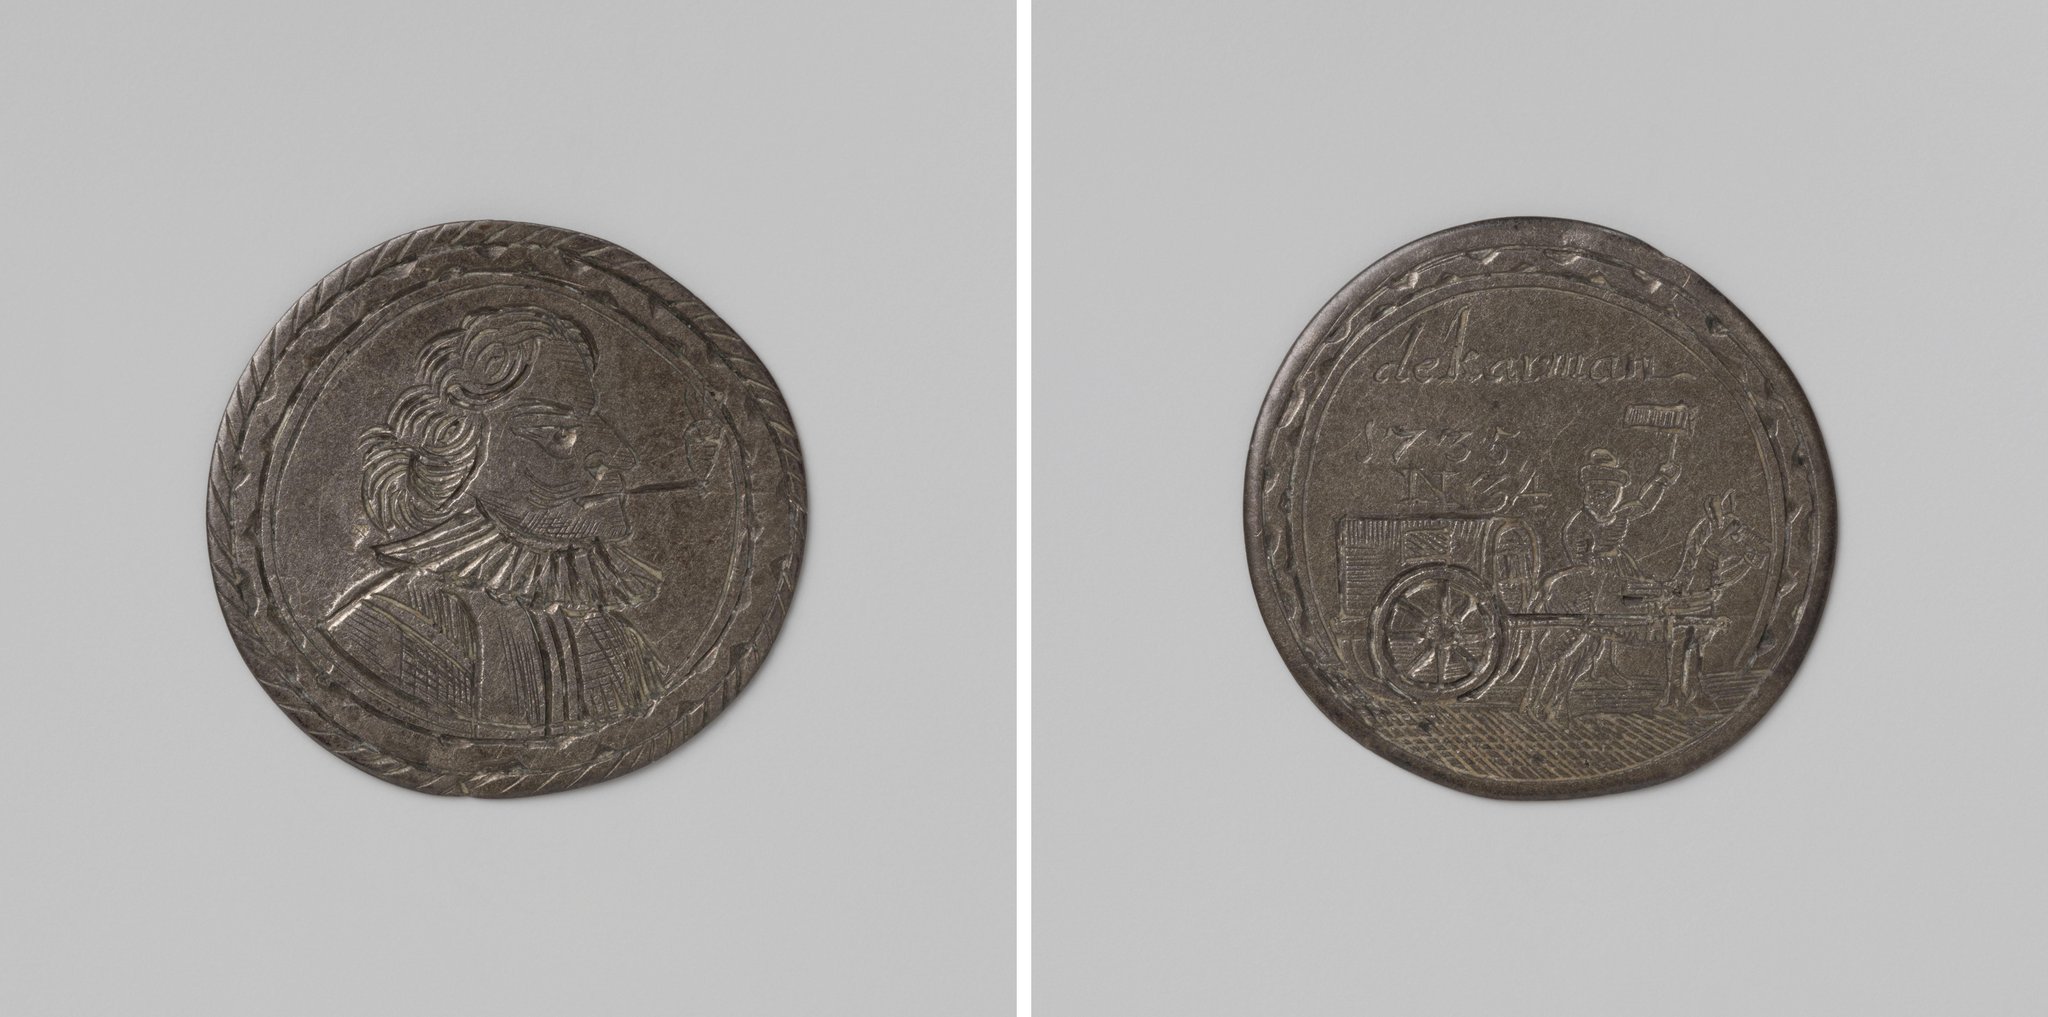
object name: beroepspenning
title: Karrevoerders, penning met no. 34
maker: Anonymous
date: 1735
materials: copper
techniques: engraving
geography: amsterdam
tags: amsterdam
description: Koperen penning. Voorzijde: borststuk pijprokende man naar links. Keerzijde: man staande naast kar onder opschrift en jaartal.